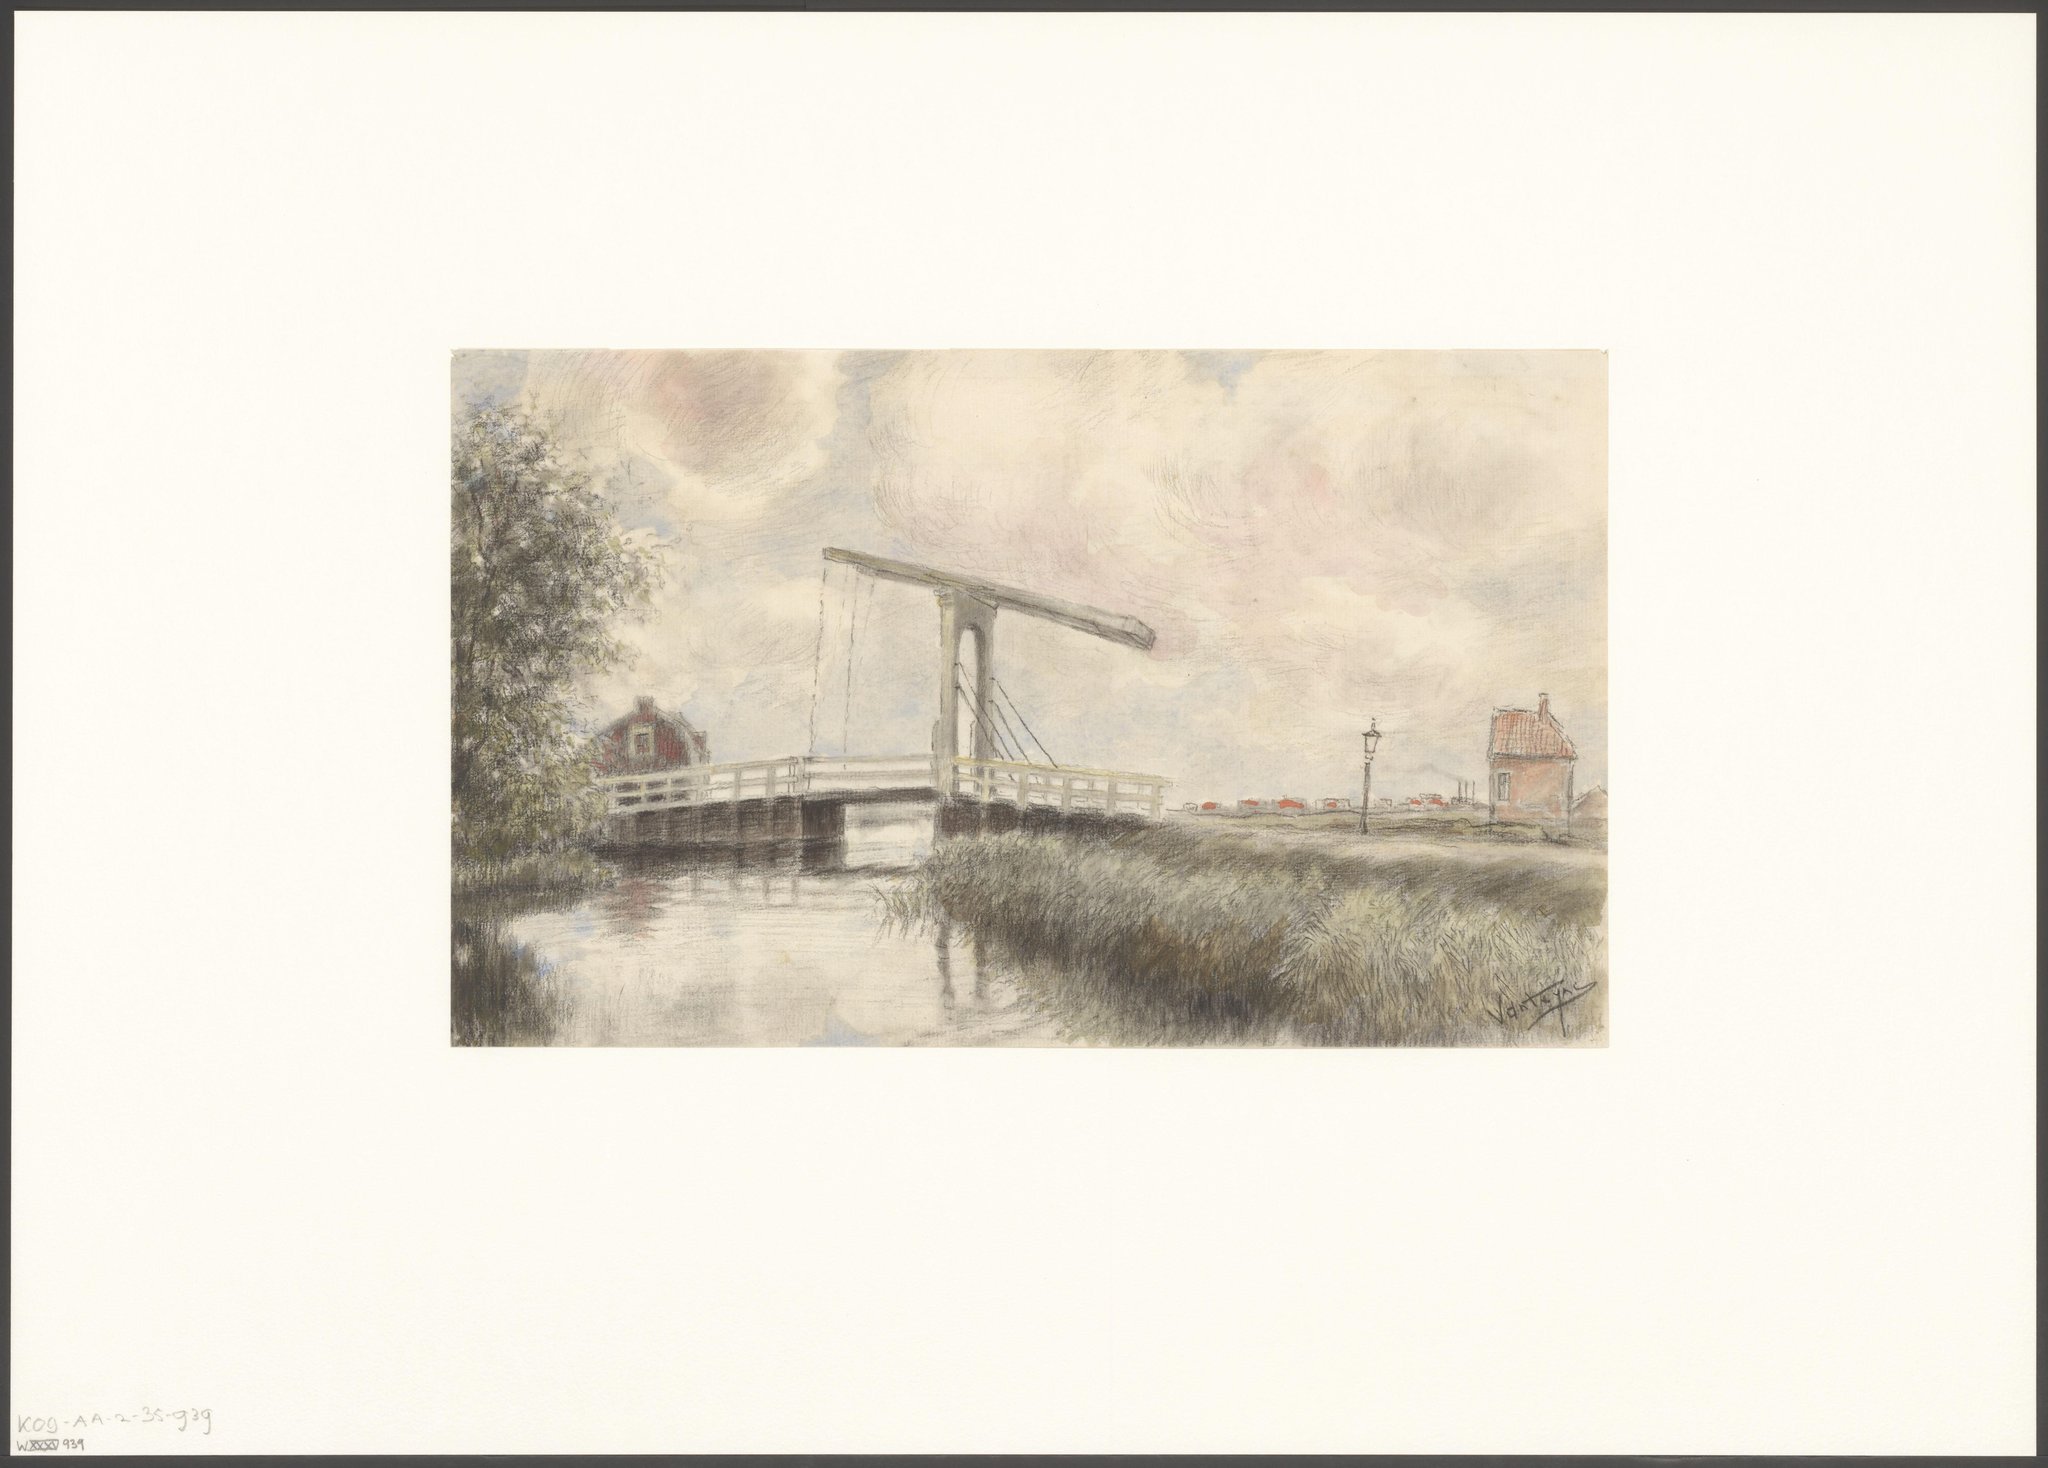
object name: drawing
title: Gezicht op de Meerbrug te Nieuwendam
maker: anthonie van teijn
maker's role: draughtsman, painter, print maker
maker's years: 1863-1943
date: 1873-1943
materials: chalk, paper, watercolor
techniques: brush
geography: amsterdam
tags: canal, village, bridge in village across river, canal, etc.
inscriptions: inscription: ‘meerbrug à Nieuwendam’, collector's mark: Lugt 800a, signature: ‘VanTeyne’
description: Tekening binnen de Atlas Van Eck ingedeeld op wijknummer 35.